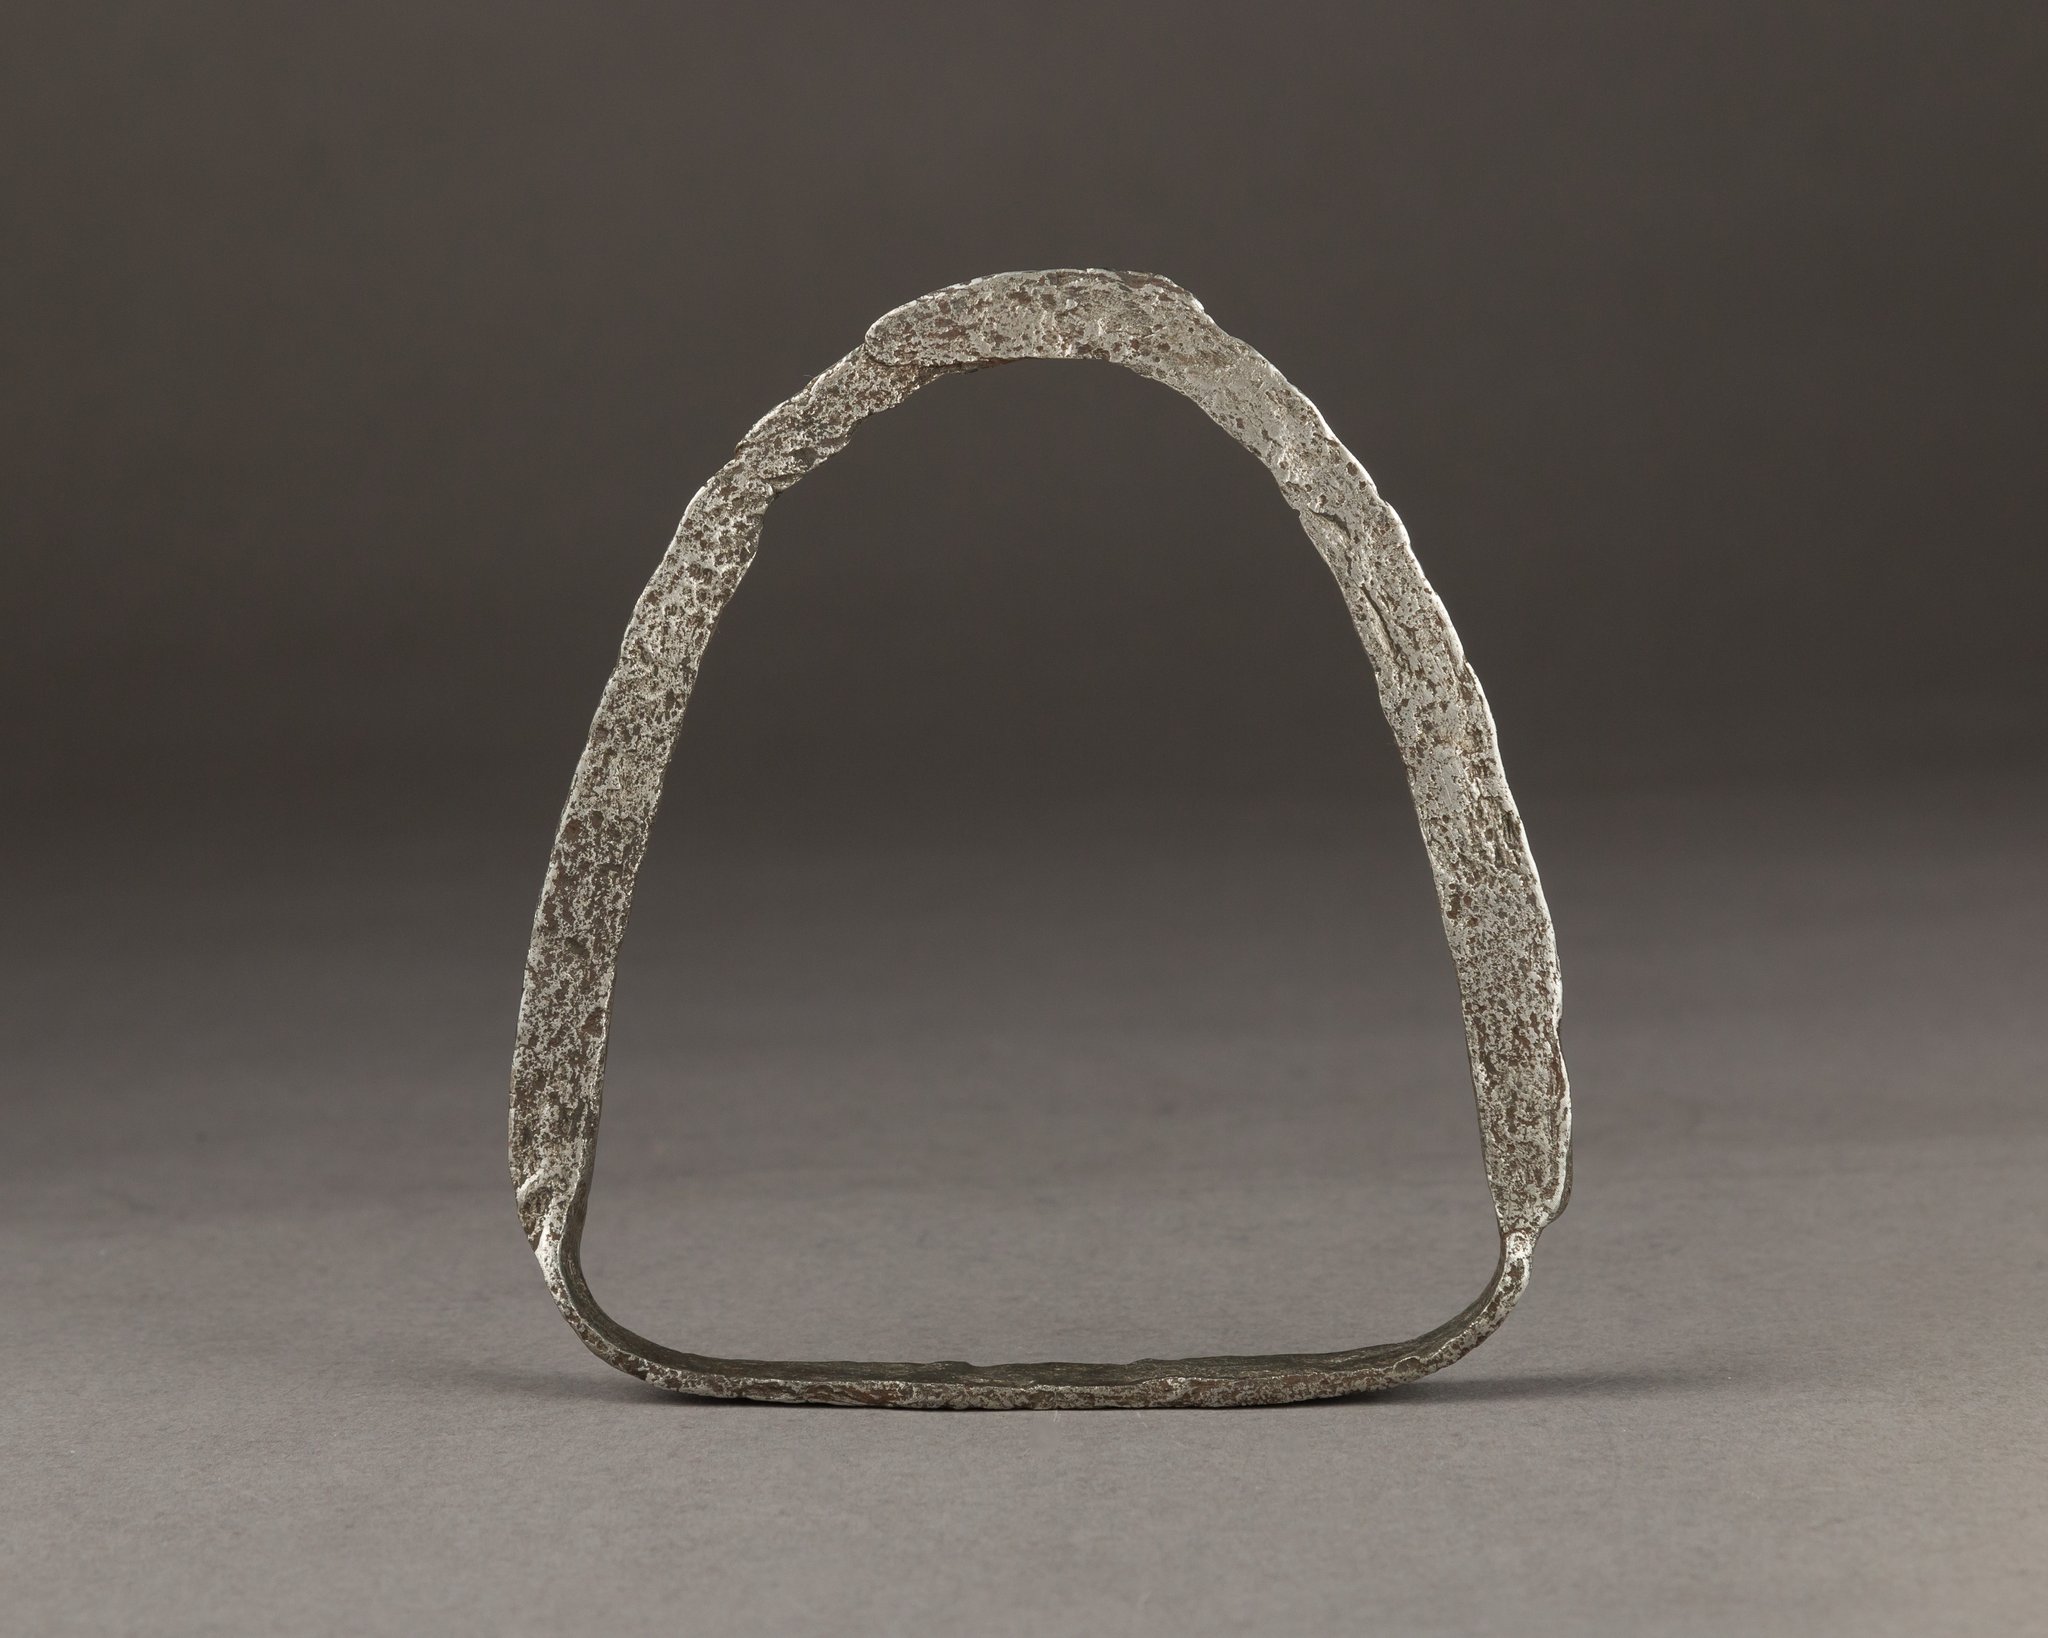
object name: stirrup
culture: west slavic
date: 901-1100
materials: iron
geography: poland